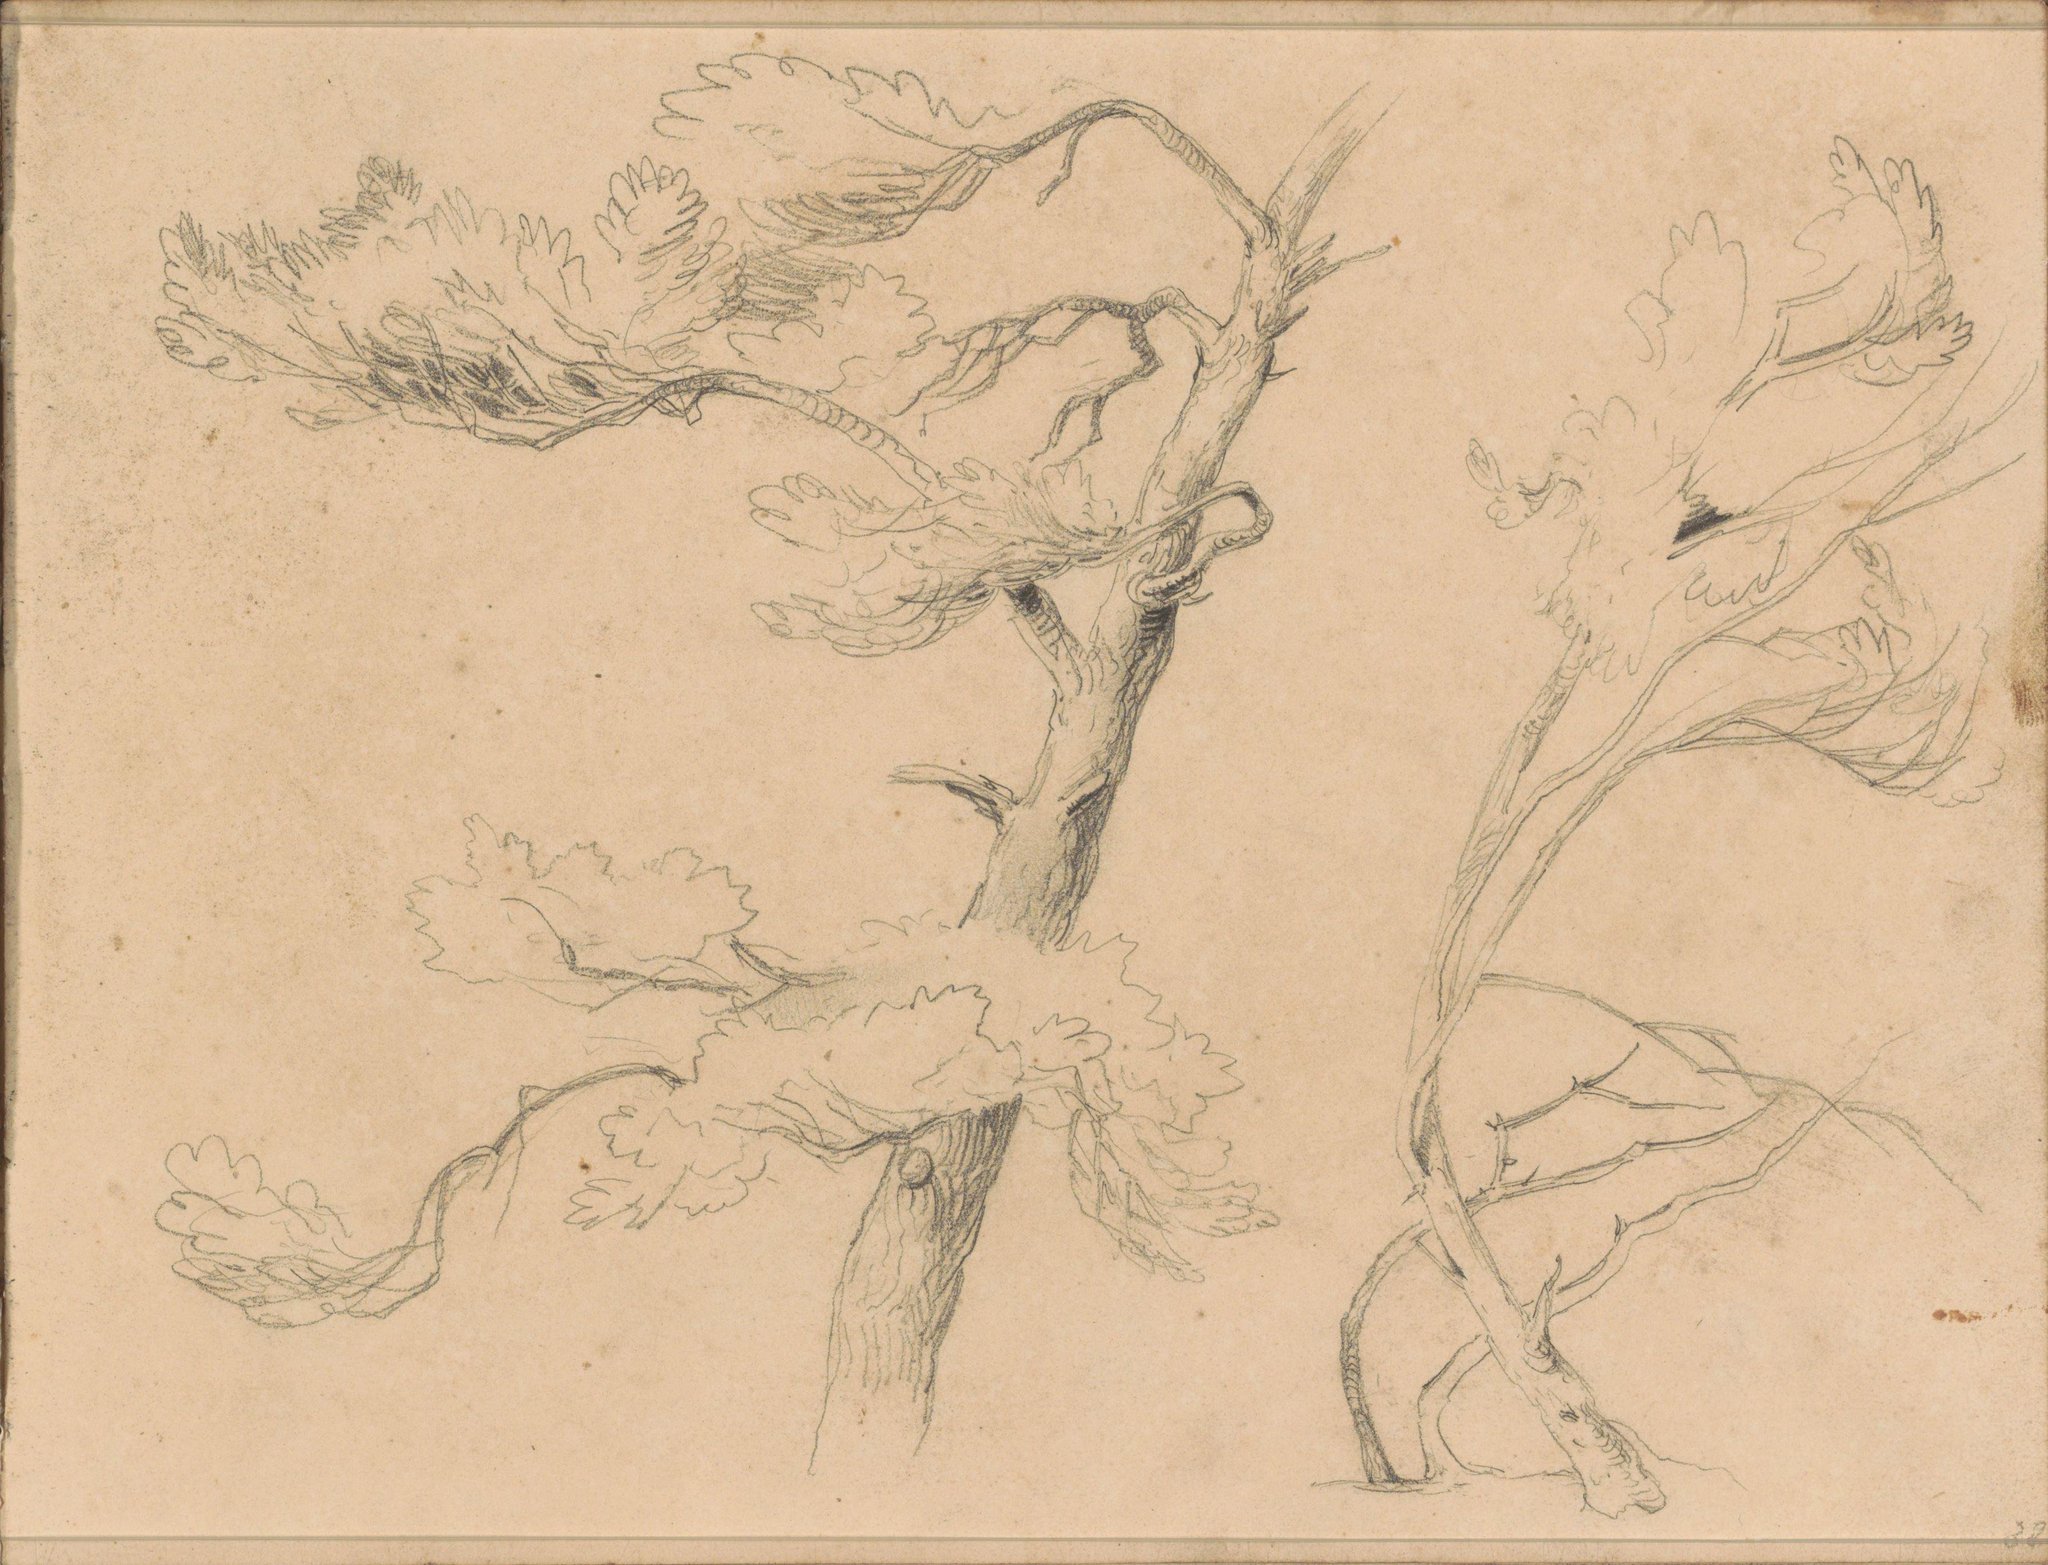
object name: sketchbook leaf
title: Boomtakken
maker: johannes tavenraat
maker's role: draughtsman, painter, print maker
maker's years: 1809-1881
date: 1840-1845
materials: paper, pencil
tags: trees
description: Blad 38 recto uit een schetsboek met 43 bladen.